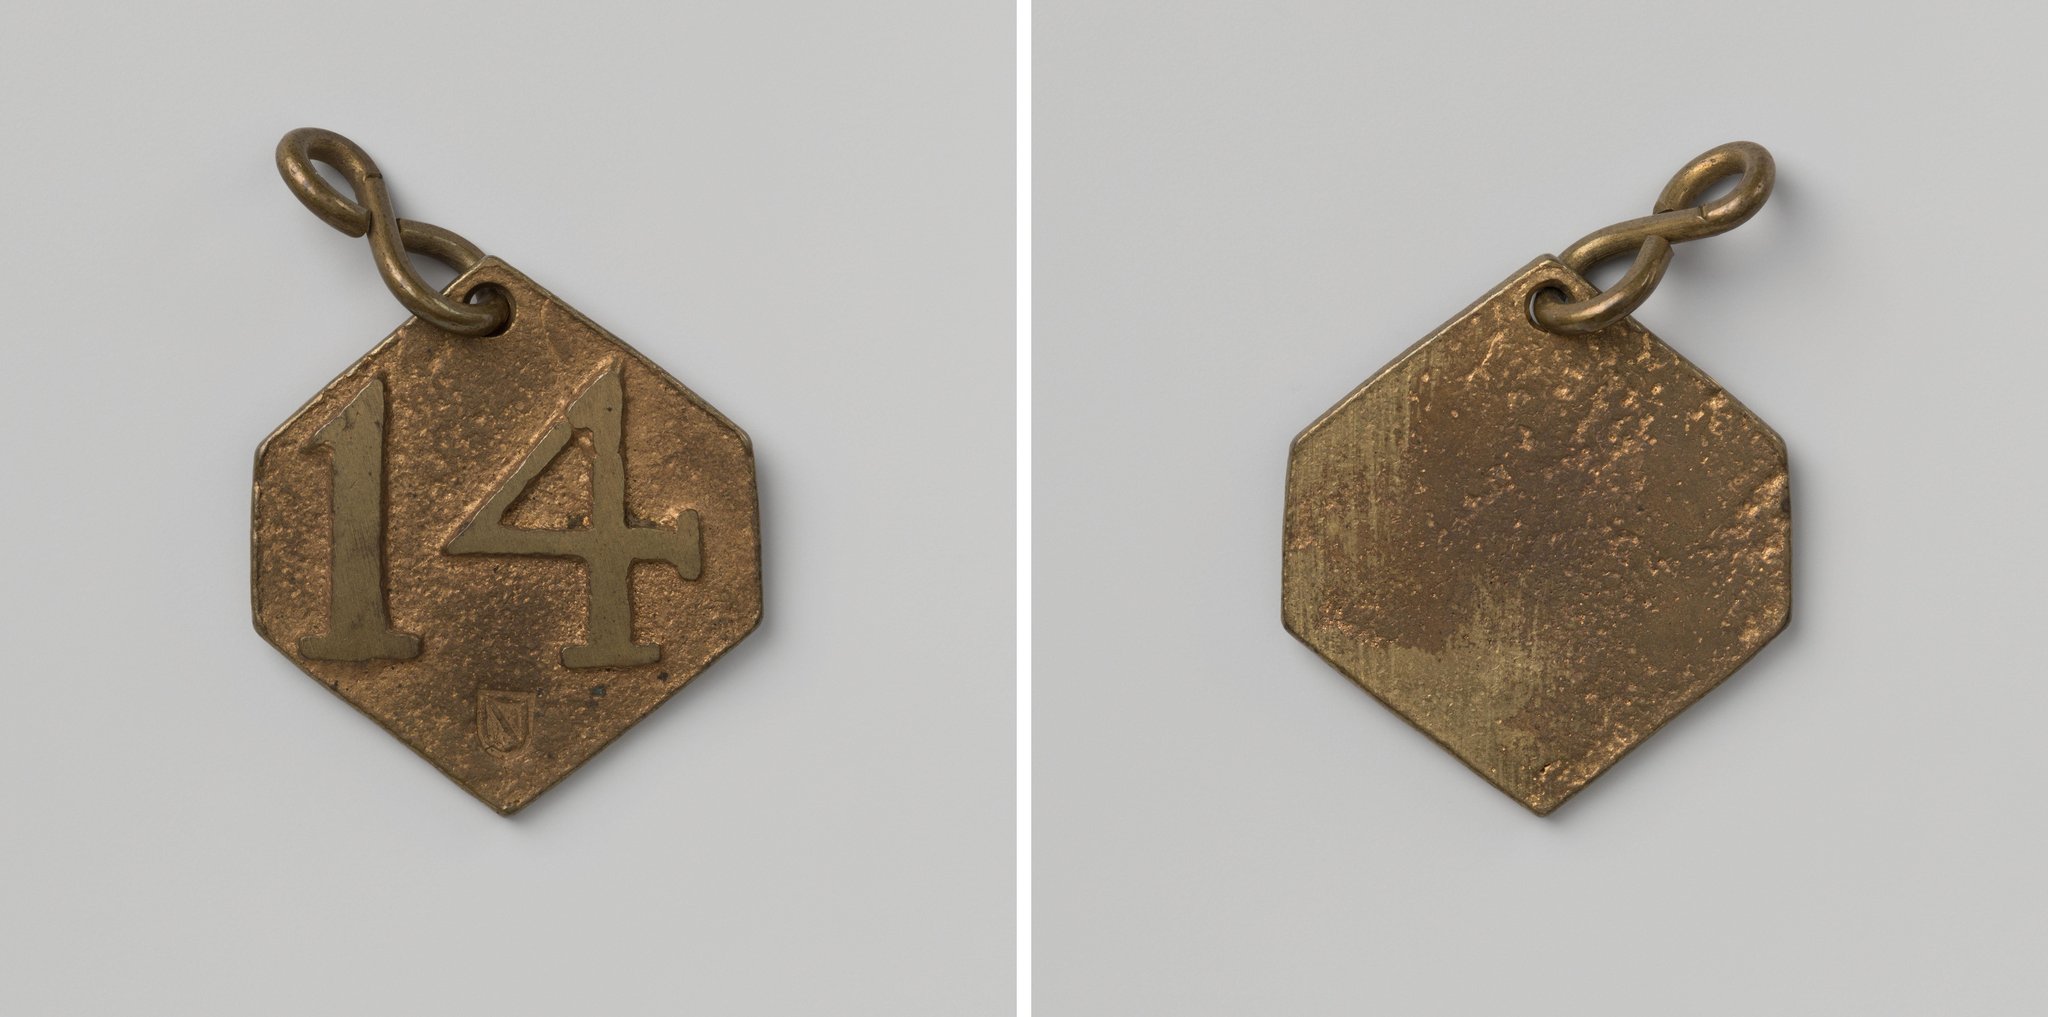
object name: hondenbelastingloodje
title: Stad Utrecht, loodje met no. 14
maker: Anonymous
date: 1800-1875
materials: brass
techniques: casting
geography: utrecht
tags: utrecht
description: Eenzijdig, zeshoekig loodje met gat erin aan draagring. Voorzijde: cijfer 14 boven wapenschild. Keerzijde: blanco. Mogelijk een hondenbelastingloodje.